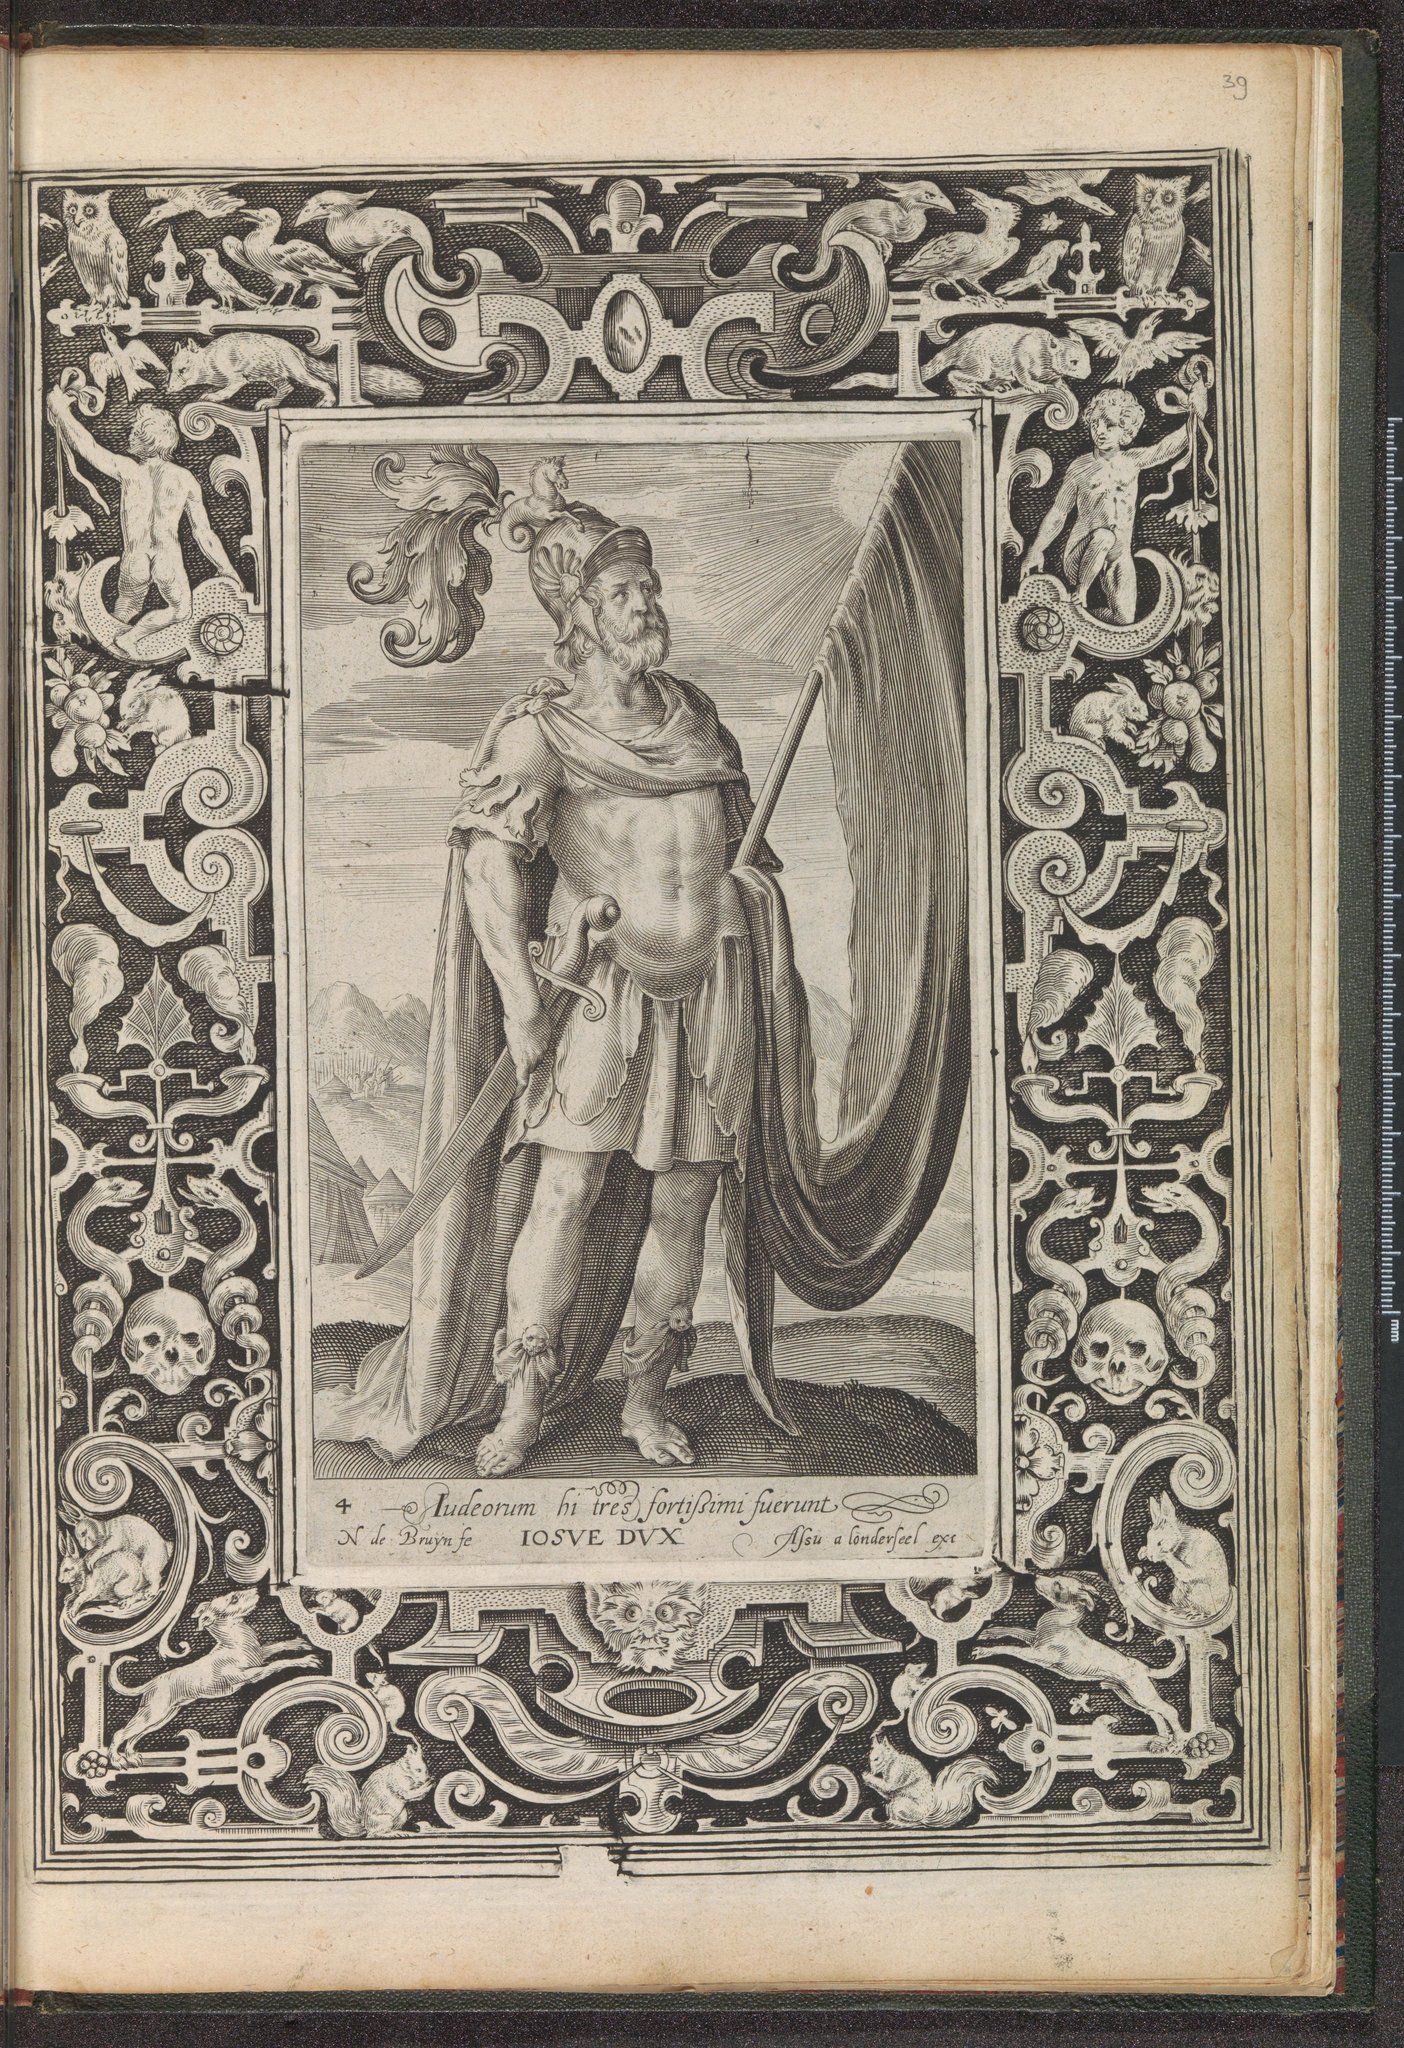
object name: album leaf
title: Negen besten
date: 1582-1635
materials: paper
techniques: engraving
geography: low countries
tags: joshua (one of the nine worthies)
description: Jozua, een beroemde veldheer uit het Oude Testament, staat met een zwaard en een vaandel in de handen in een landschap. Hij maakt deel uit van De Negen Besten. Onder de voorstelling een vers in het Latijn. De voorstelling is gevat in een omlijsting met krulornamenten en verschillende dieren, zoals konijnen, honden, eekhoorns en vogels. Deze prent maakt deel uit van een album.